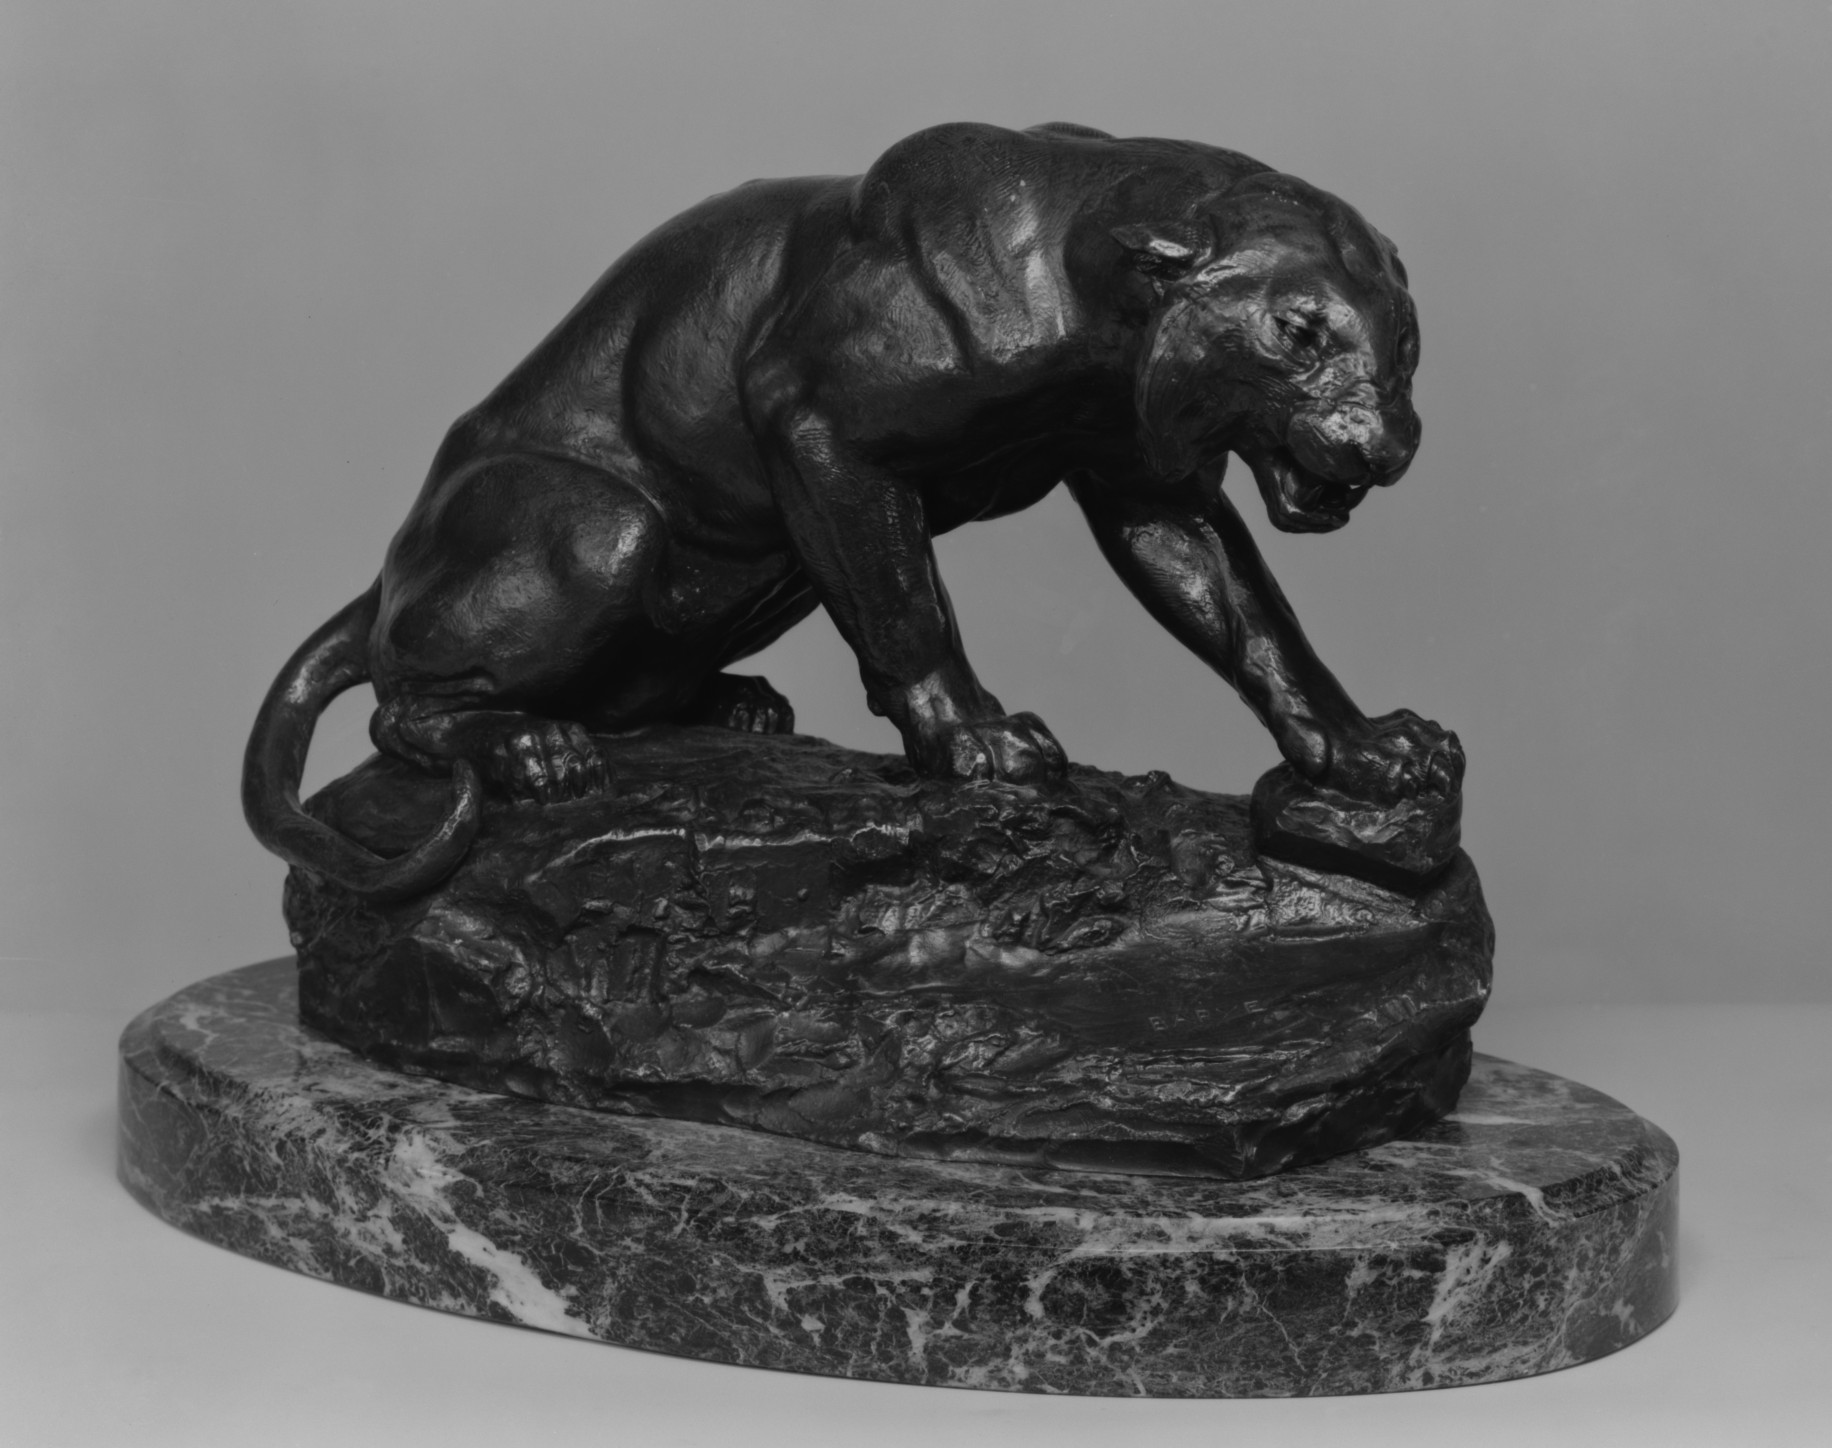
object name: statuette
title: Snarling Tiger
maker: antoine-louis barye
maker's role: artist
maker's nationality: french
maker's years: 1795-1875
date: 1801-1900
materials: bronze, marble, patina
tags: tigers